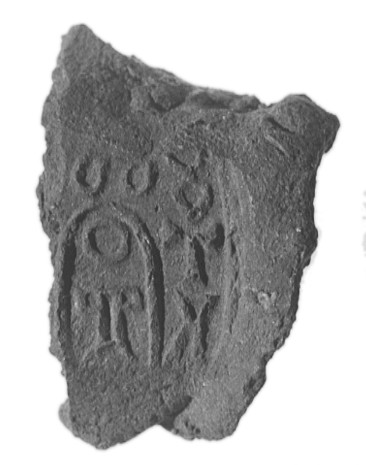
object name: sealing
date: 2030-1640 BCE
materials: clay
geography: egypt